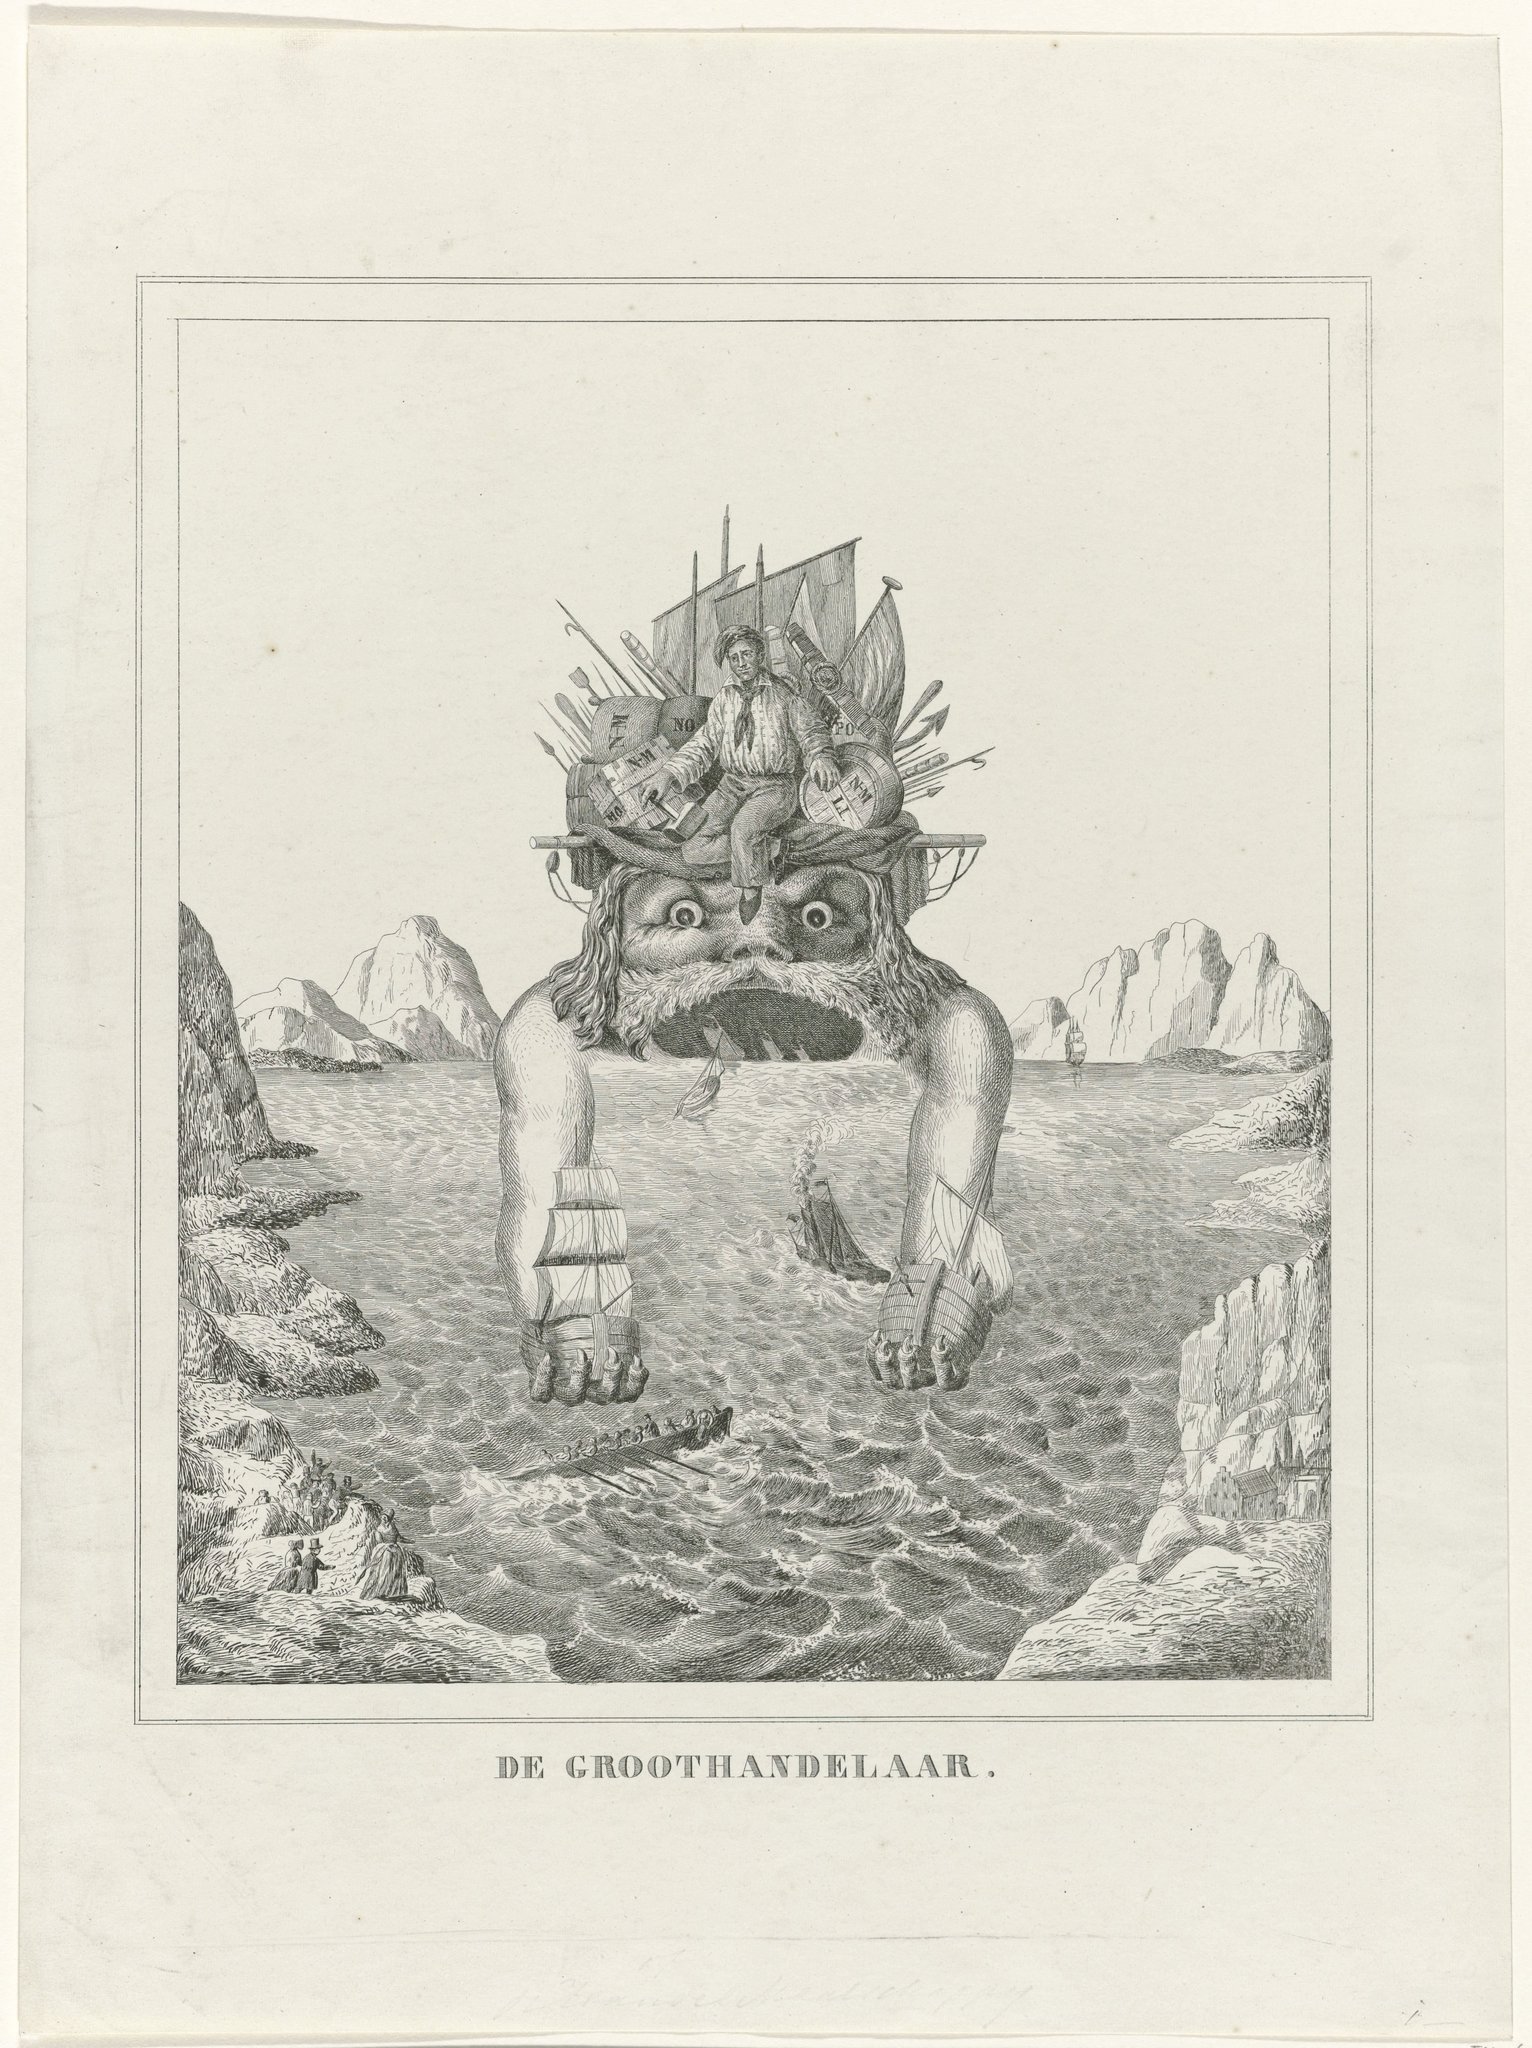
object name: cartoon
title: Spotprent op de oprichting van de Nederlandse Handelsmaatschappij, 1824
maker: Anonymous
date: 1824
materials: paper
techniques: lithograph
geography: netherlands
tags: monsters ~ mammals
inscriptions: collector's mark: Lugt 2228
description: Spotprent op de oprichting van de Nederlandse Handelsmaatschappij te Den Haag op 9 maart 1824 en de angst dat dit ten koste zou gaan van de kleinere particuliere rederijen en ondernemeningen. Een zeemonster slikt de op het water varende schepen op in zijn grote muil en grijpt met zijn klauwen andere schepen. Op de kop van het monster zit een zeeman en attributen van de koophandel.